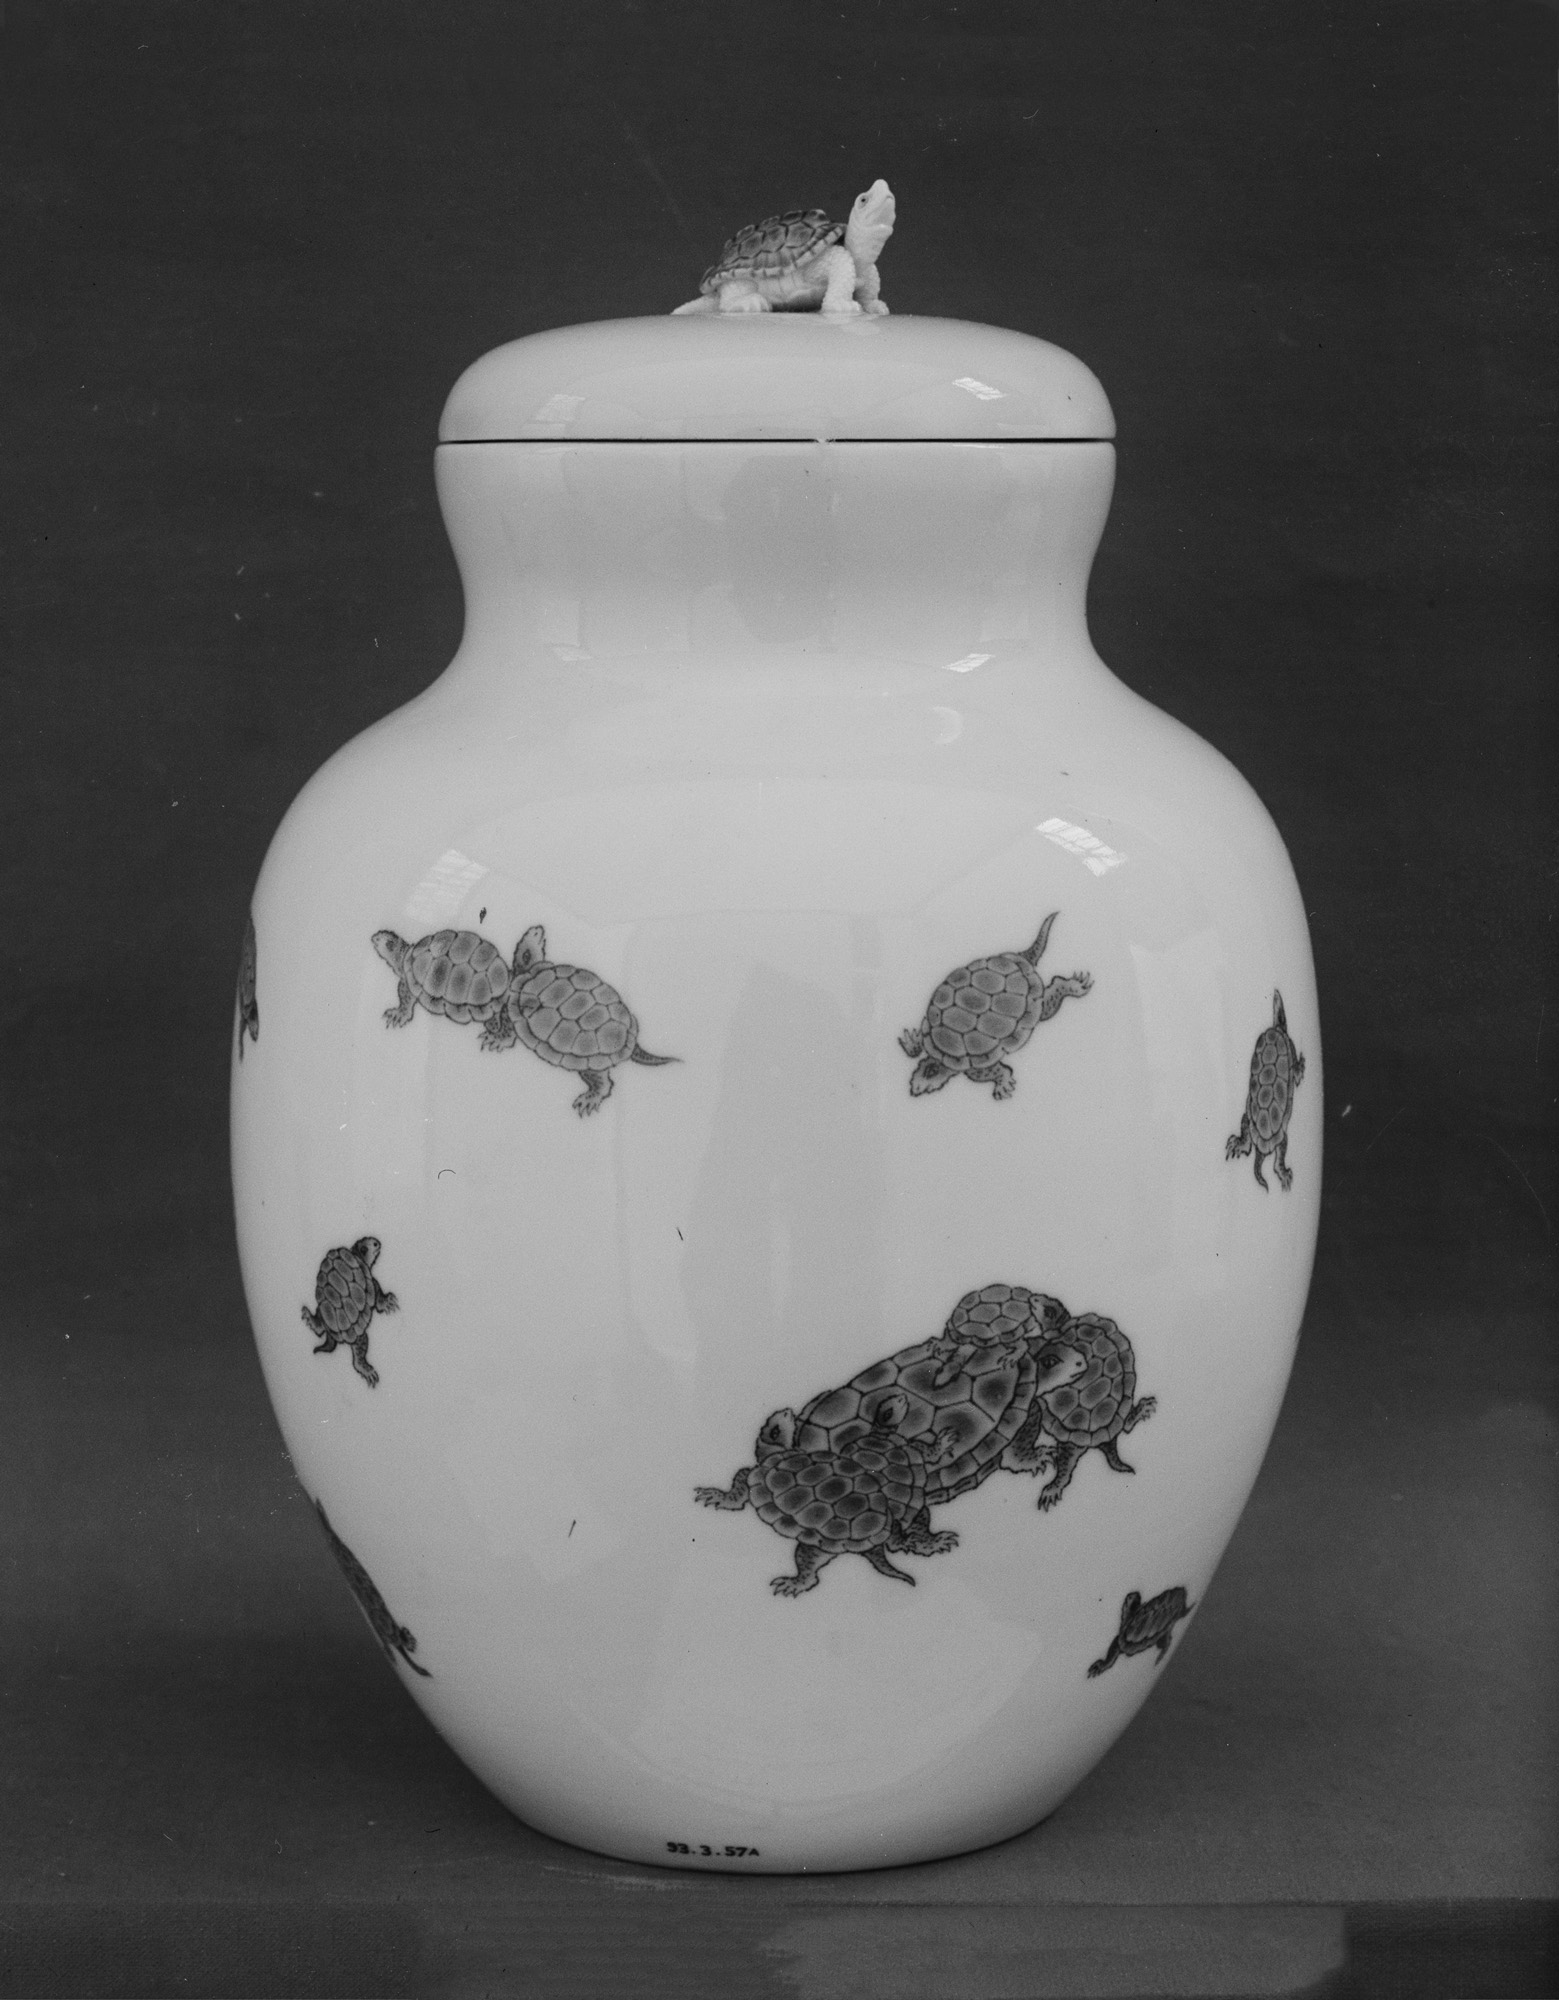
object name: jar with cover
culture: japanese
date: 1820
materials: glaze, porcelain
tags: turtles